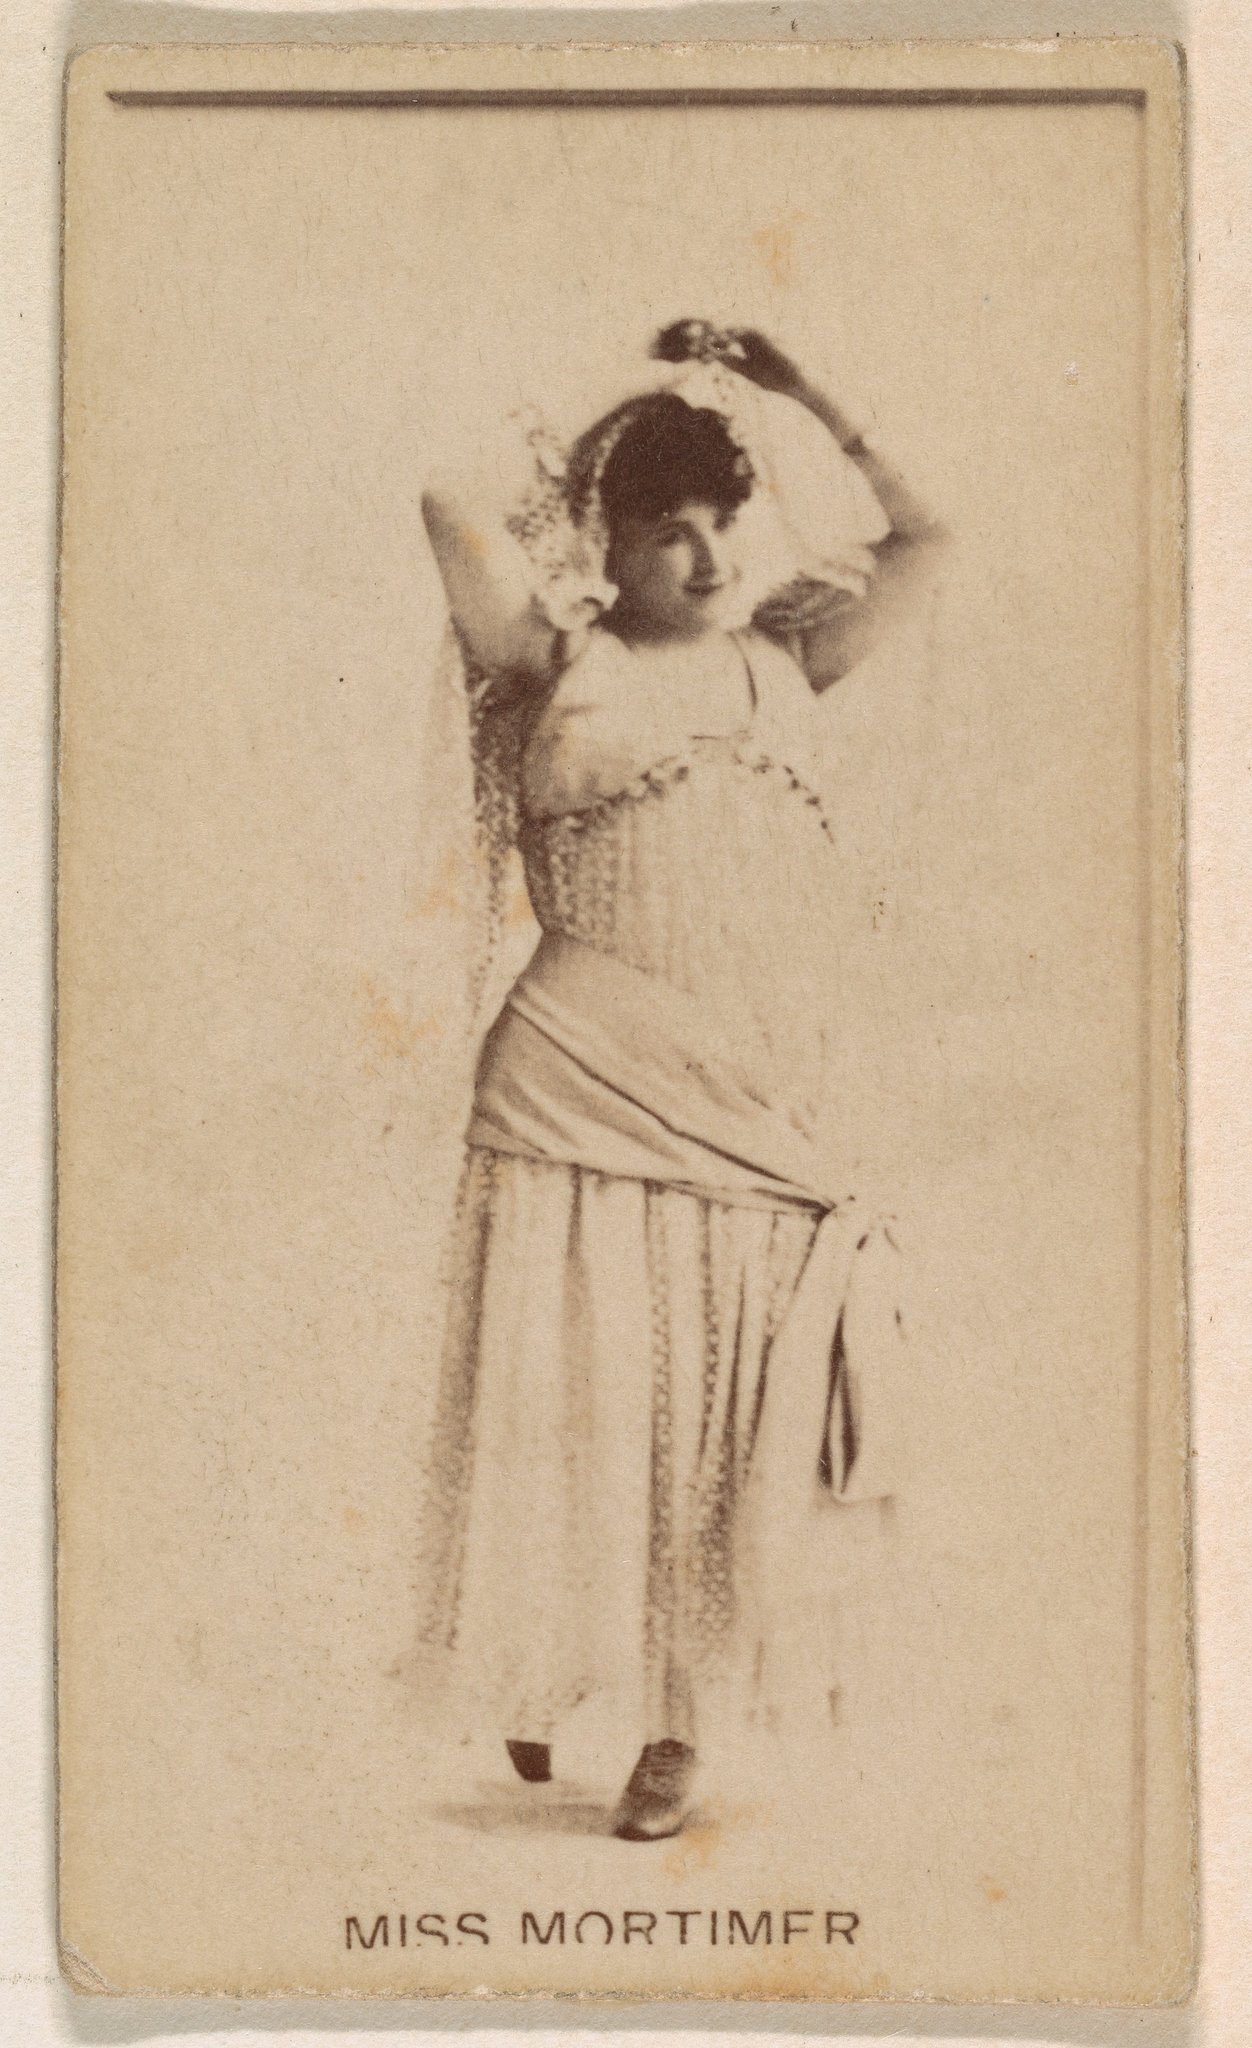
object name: photograph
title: Miss Mortimer, from the Actresses series (N245) issued by Kinney Brothers to promote Sweet Caporal Cigarettes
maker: kinney brothers tobacco company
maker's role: publisher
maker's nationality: american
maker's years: 1869-2011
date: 1890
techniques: albumen silver print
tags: portraits,women,actresses